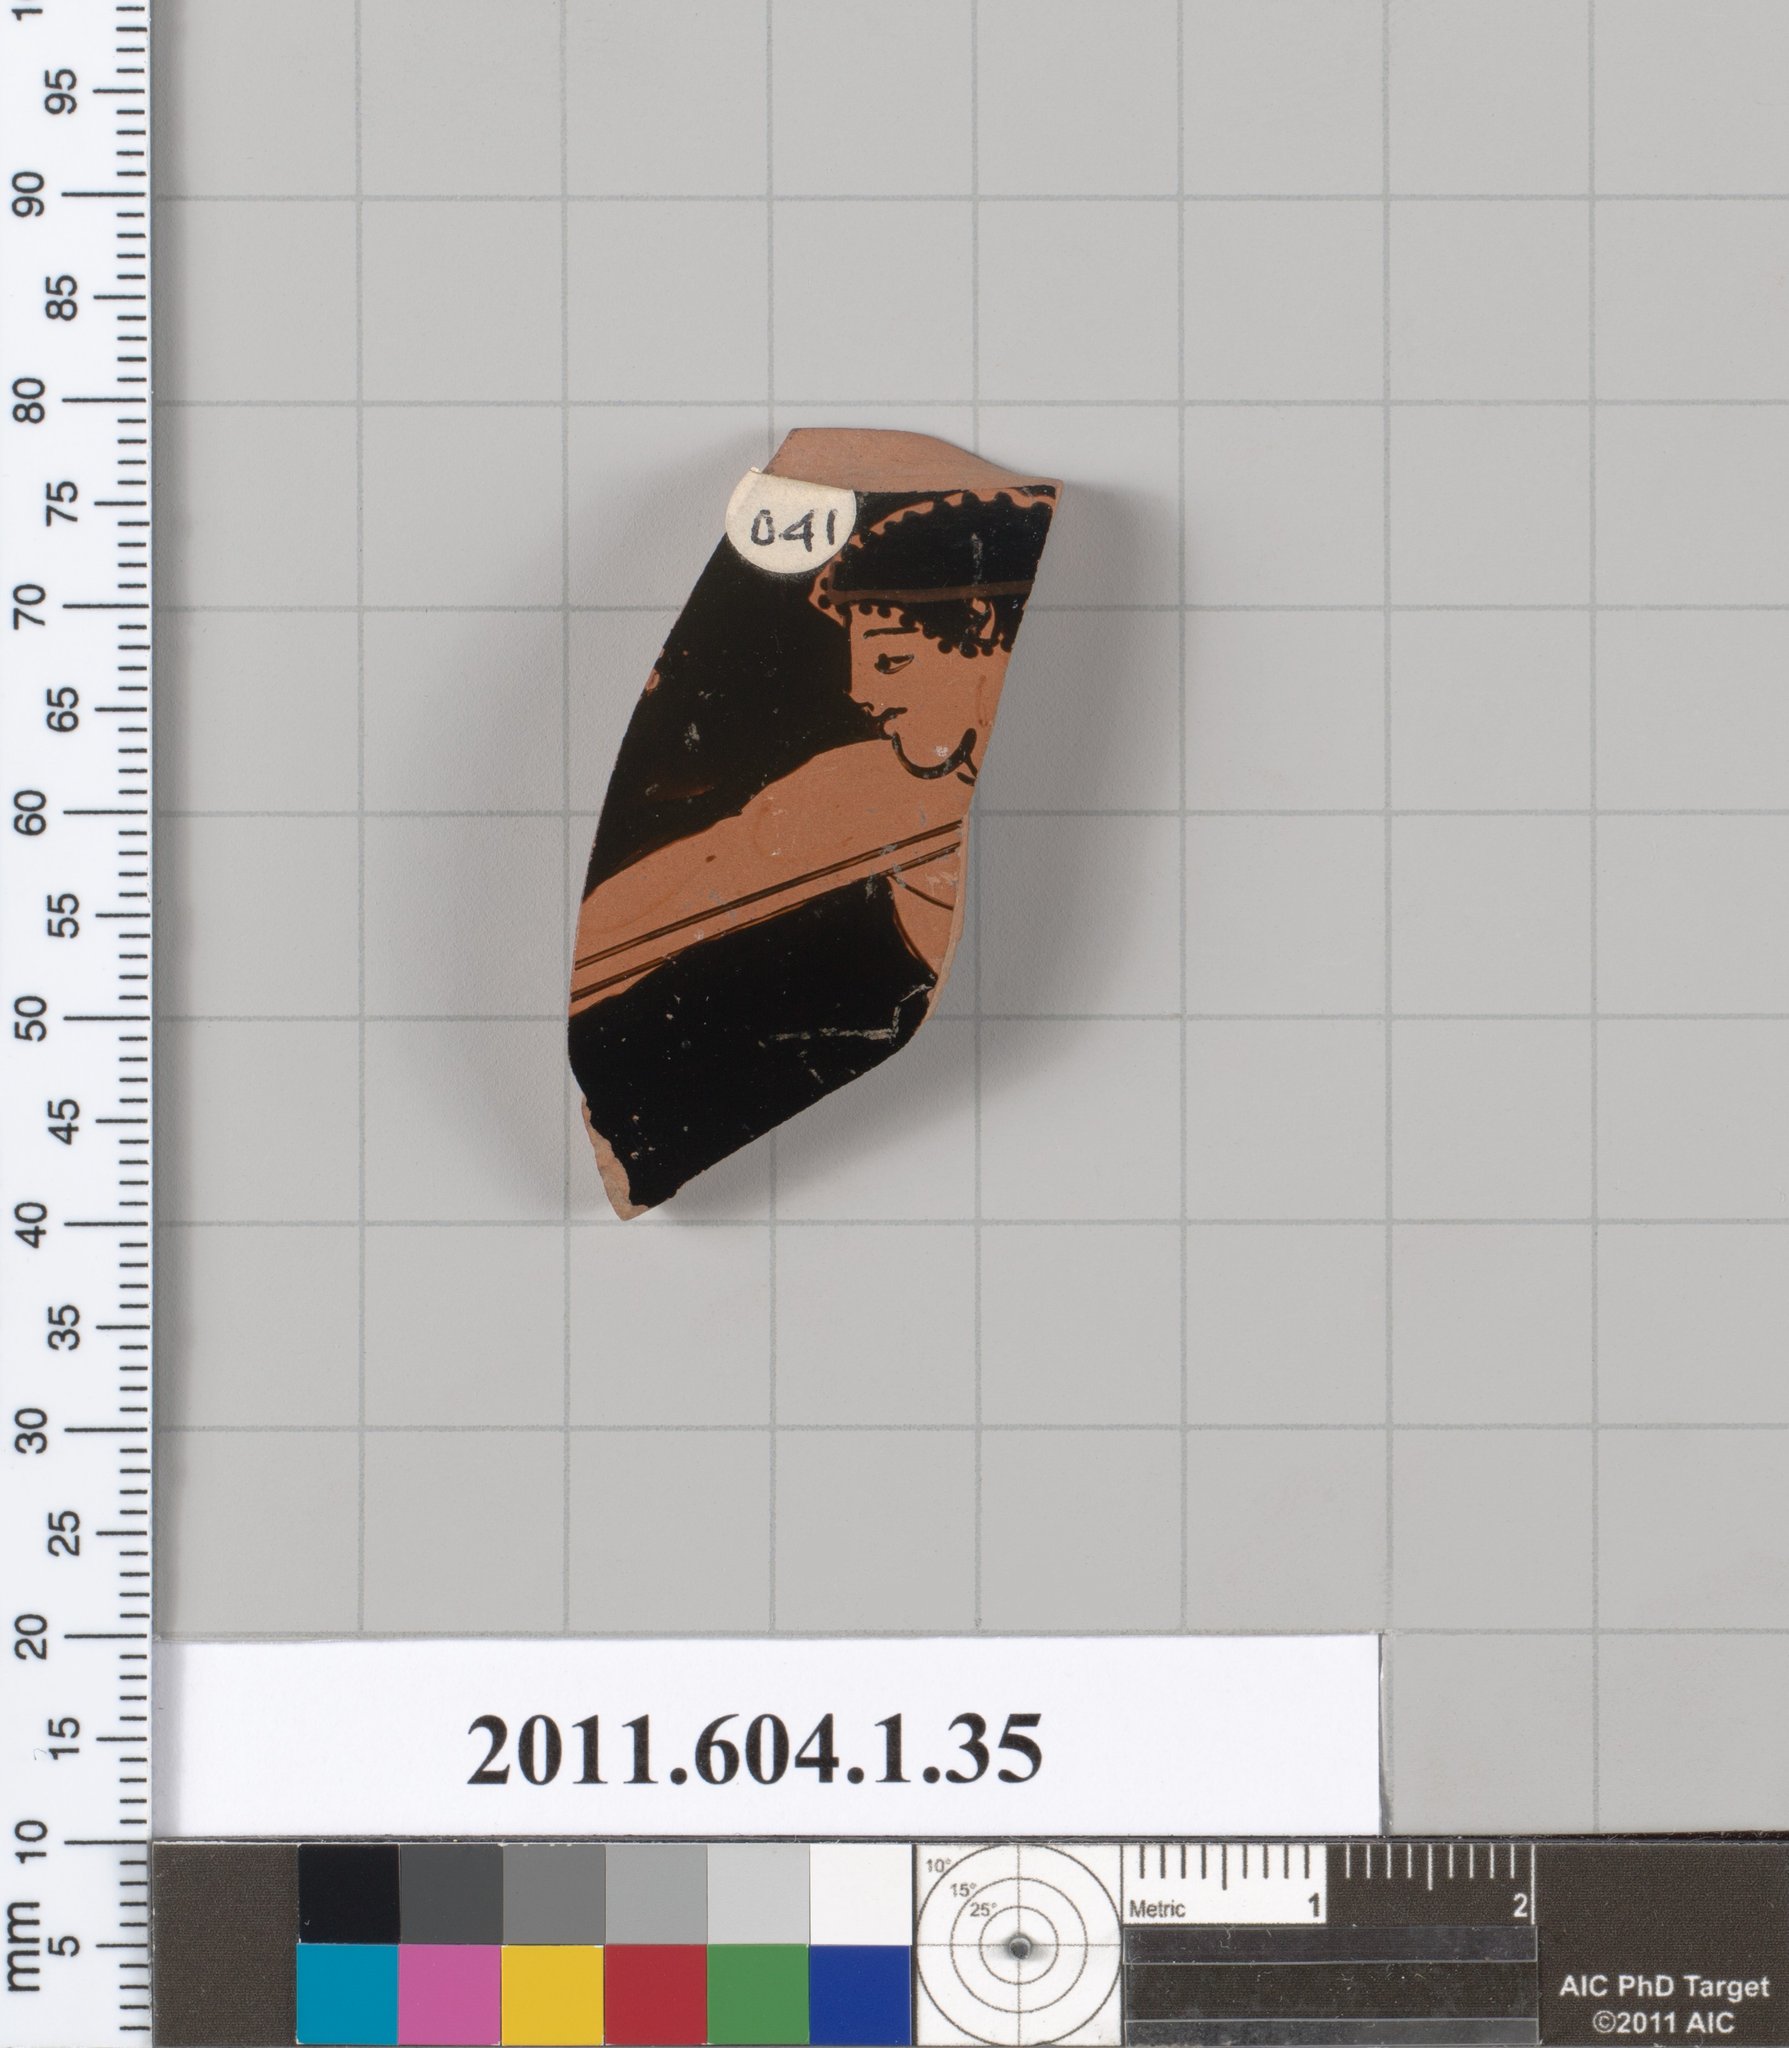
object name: kylix fragment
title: Terracotta fragment of a kylix (drinking cup)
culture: greek, attic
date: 490-480 BCE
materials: terracotta